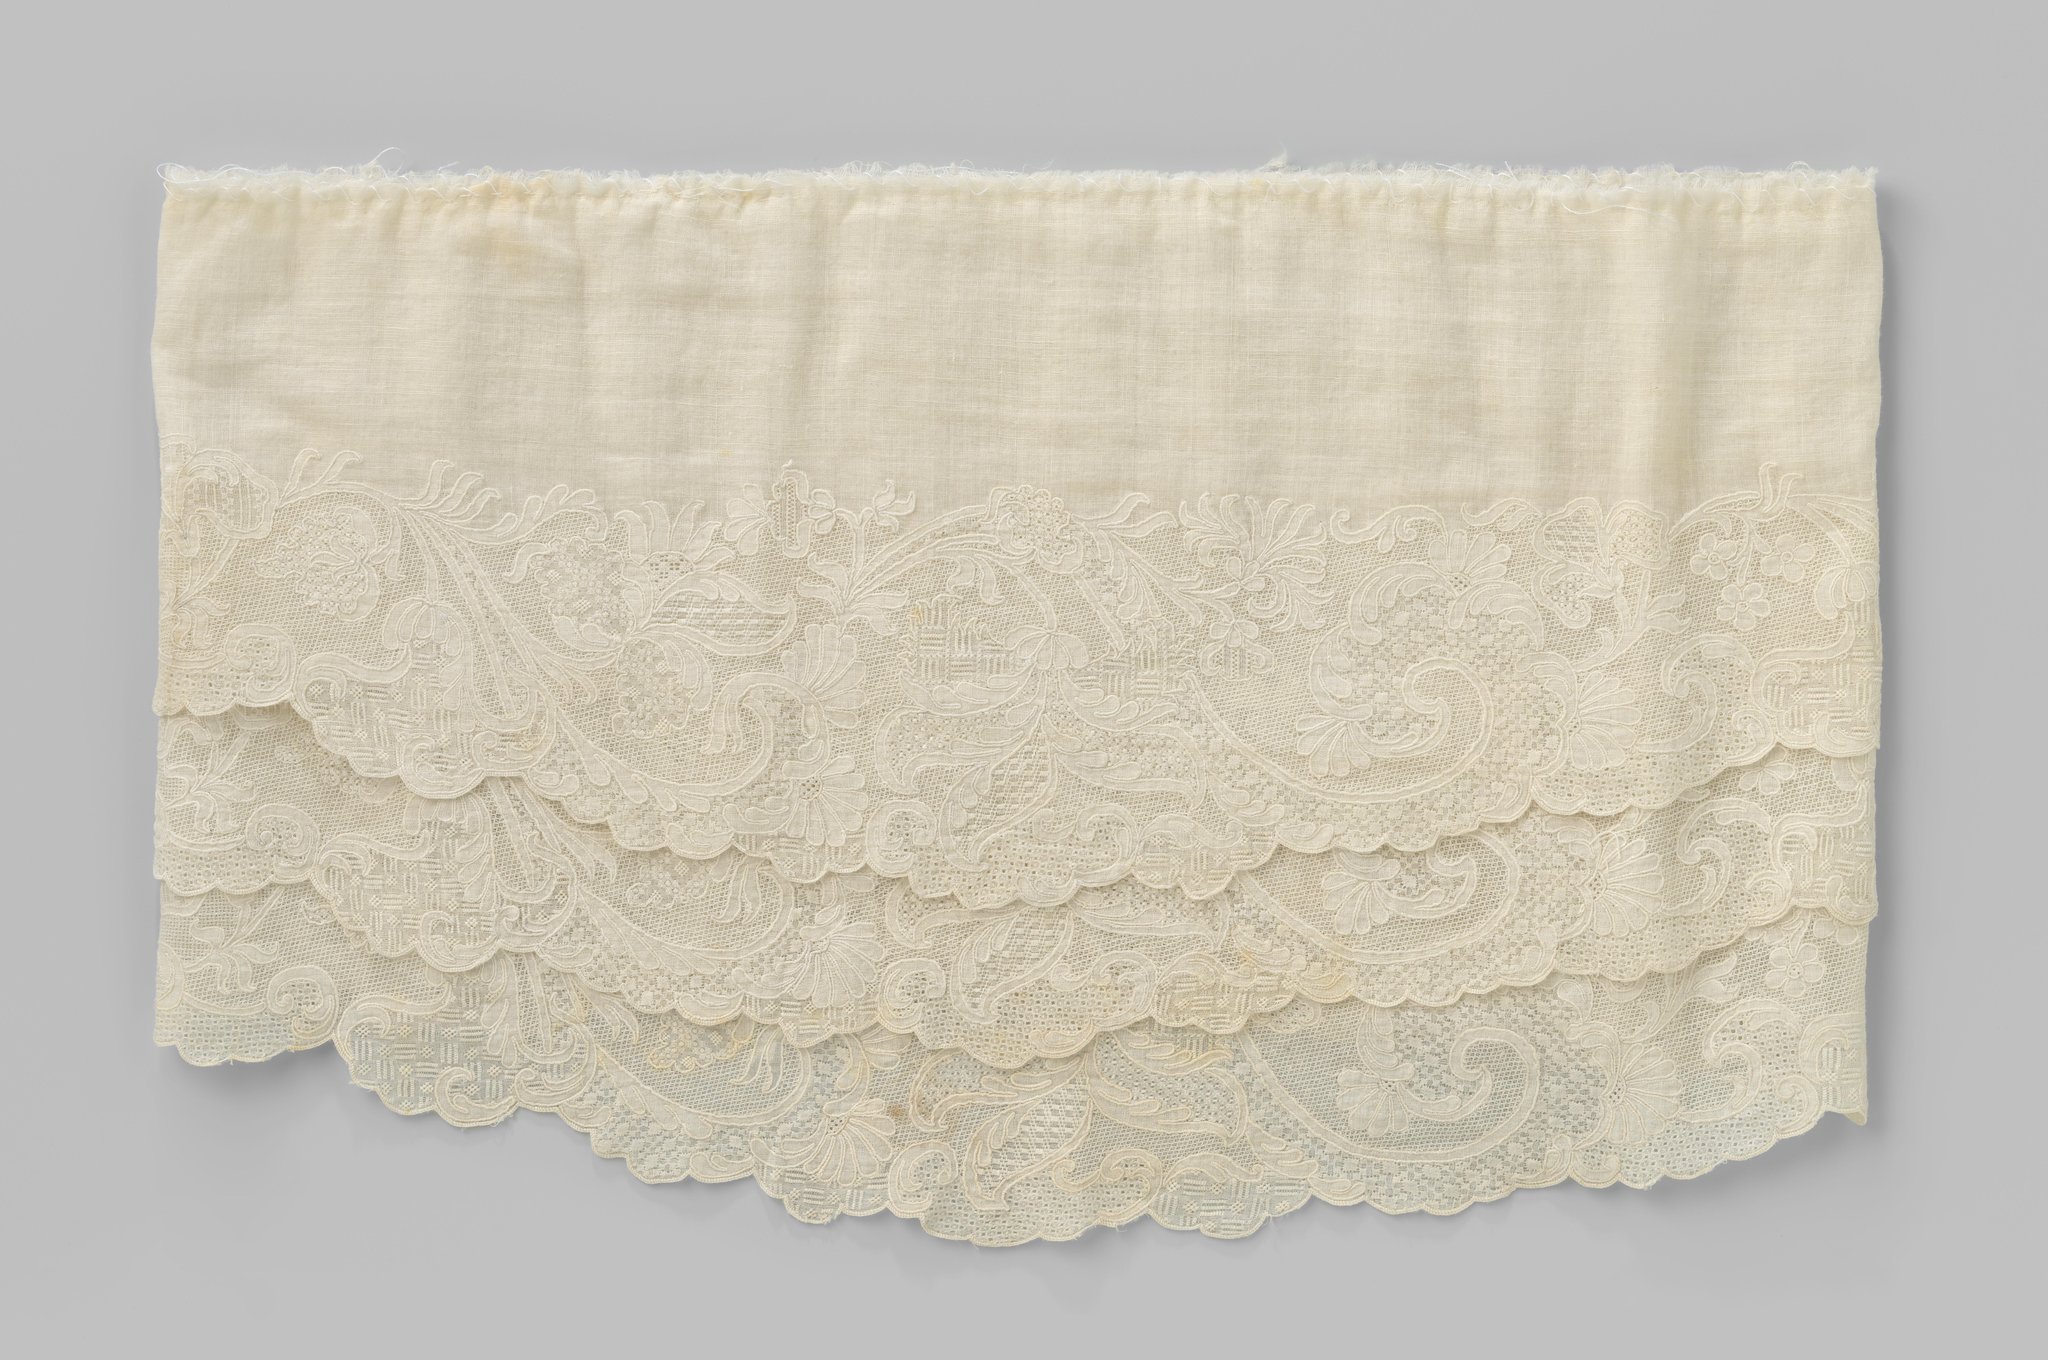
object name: womenswear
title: Witte mouw met drie lagen wit geschulpte kant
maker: Anonymous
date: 1850-1920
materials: textile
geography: europe